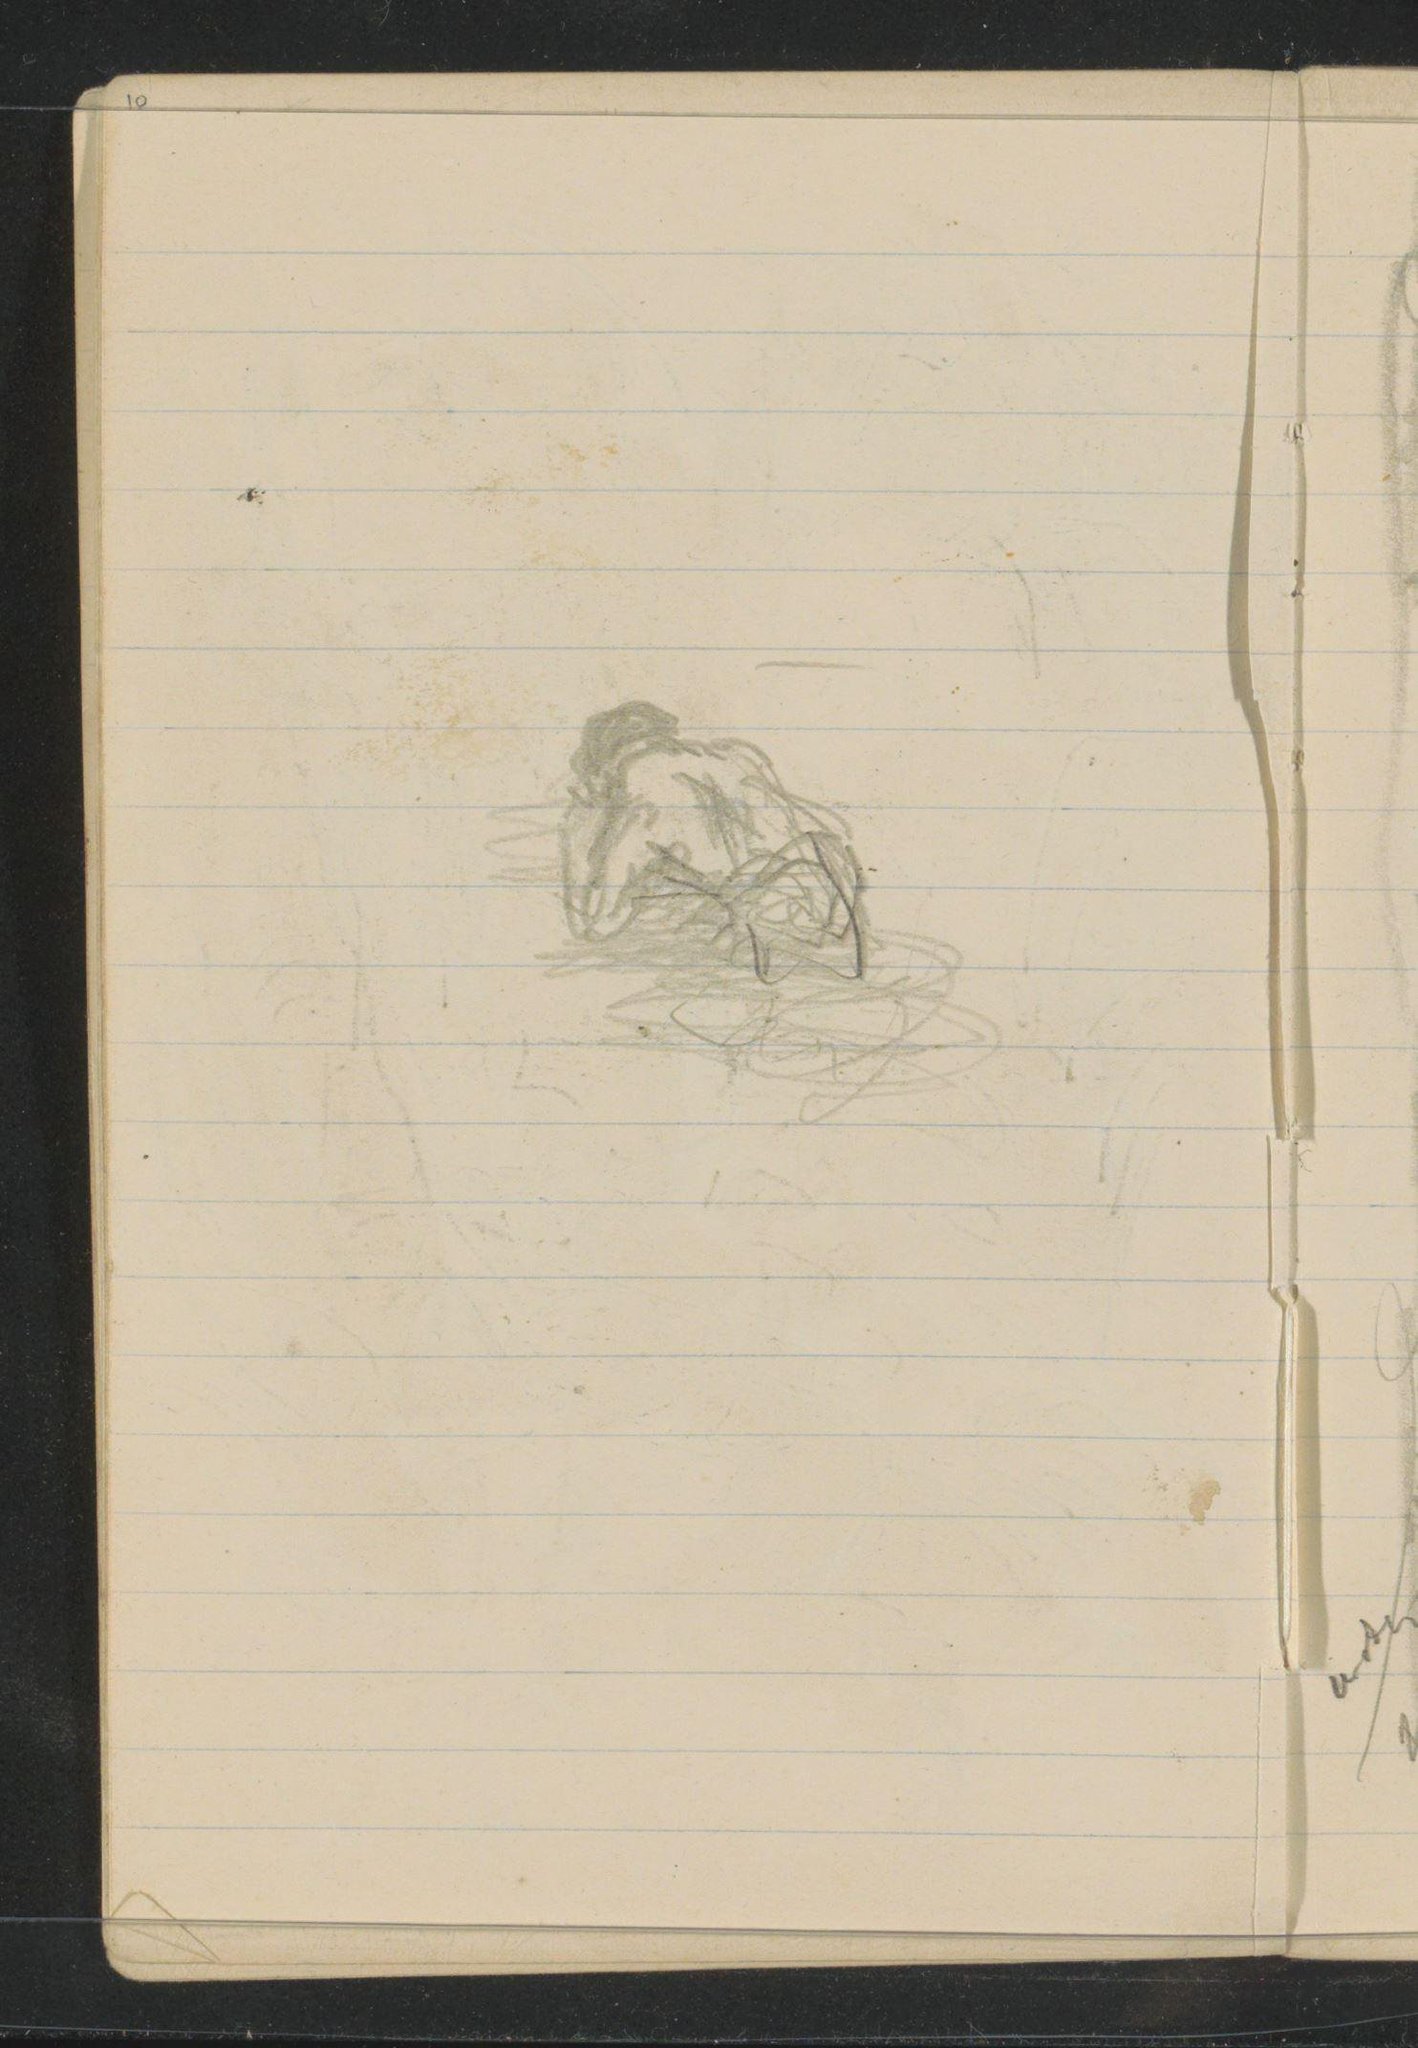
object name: sketchbook leaf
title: Bukkende figuur, van achteren gezien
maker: marius bauer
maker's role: draughtsman, print maker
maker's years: 1867-1932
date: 1931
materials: pencil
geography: java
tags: bending figure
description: Vermoedelijk staat de figuur tot zijn of haar middel in het water. Pagina 10 uit een schetsboek met 74 bladen.